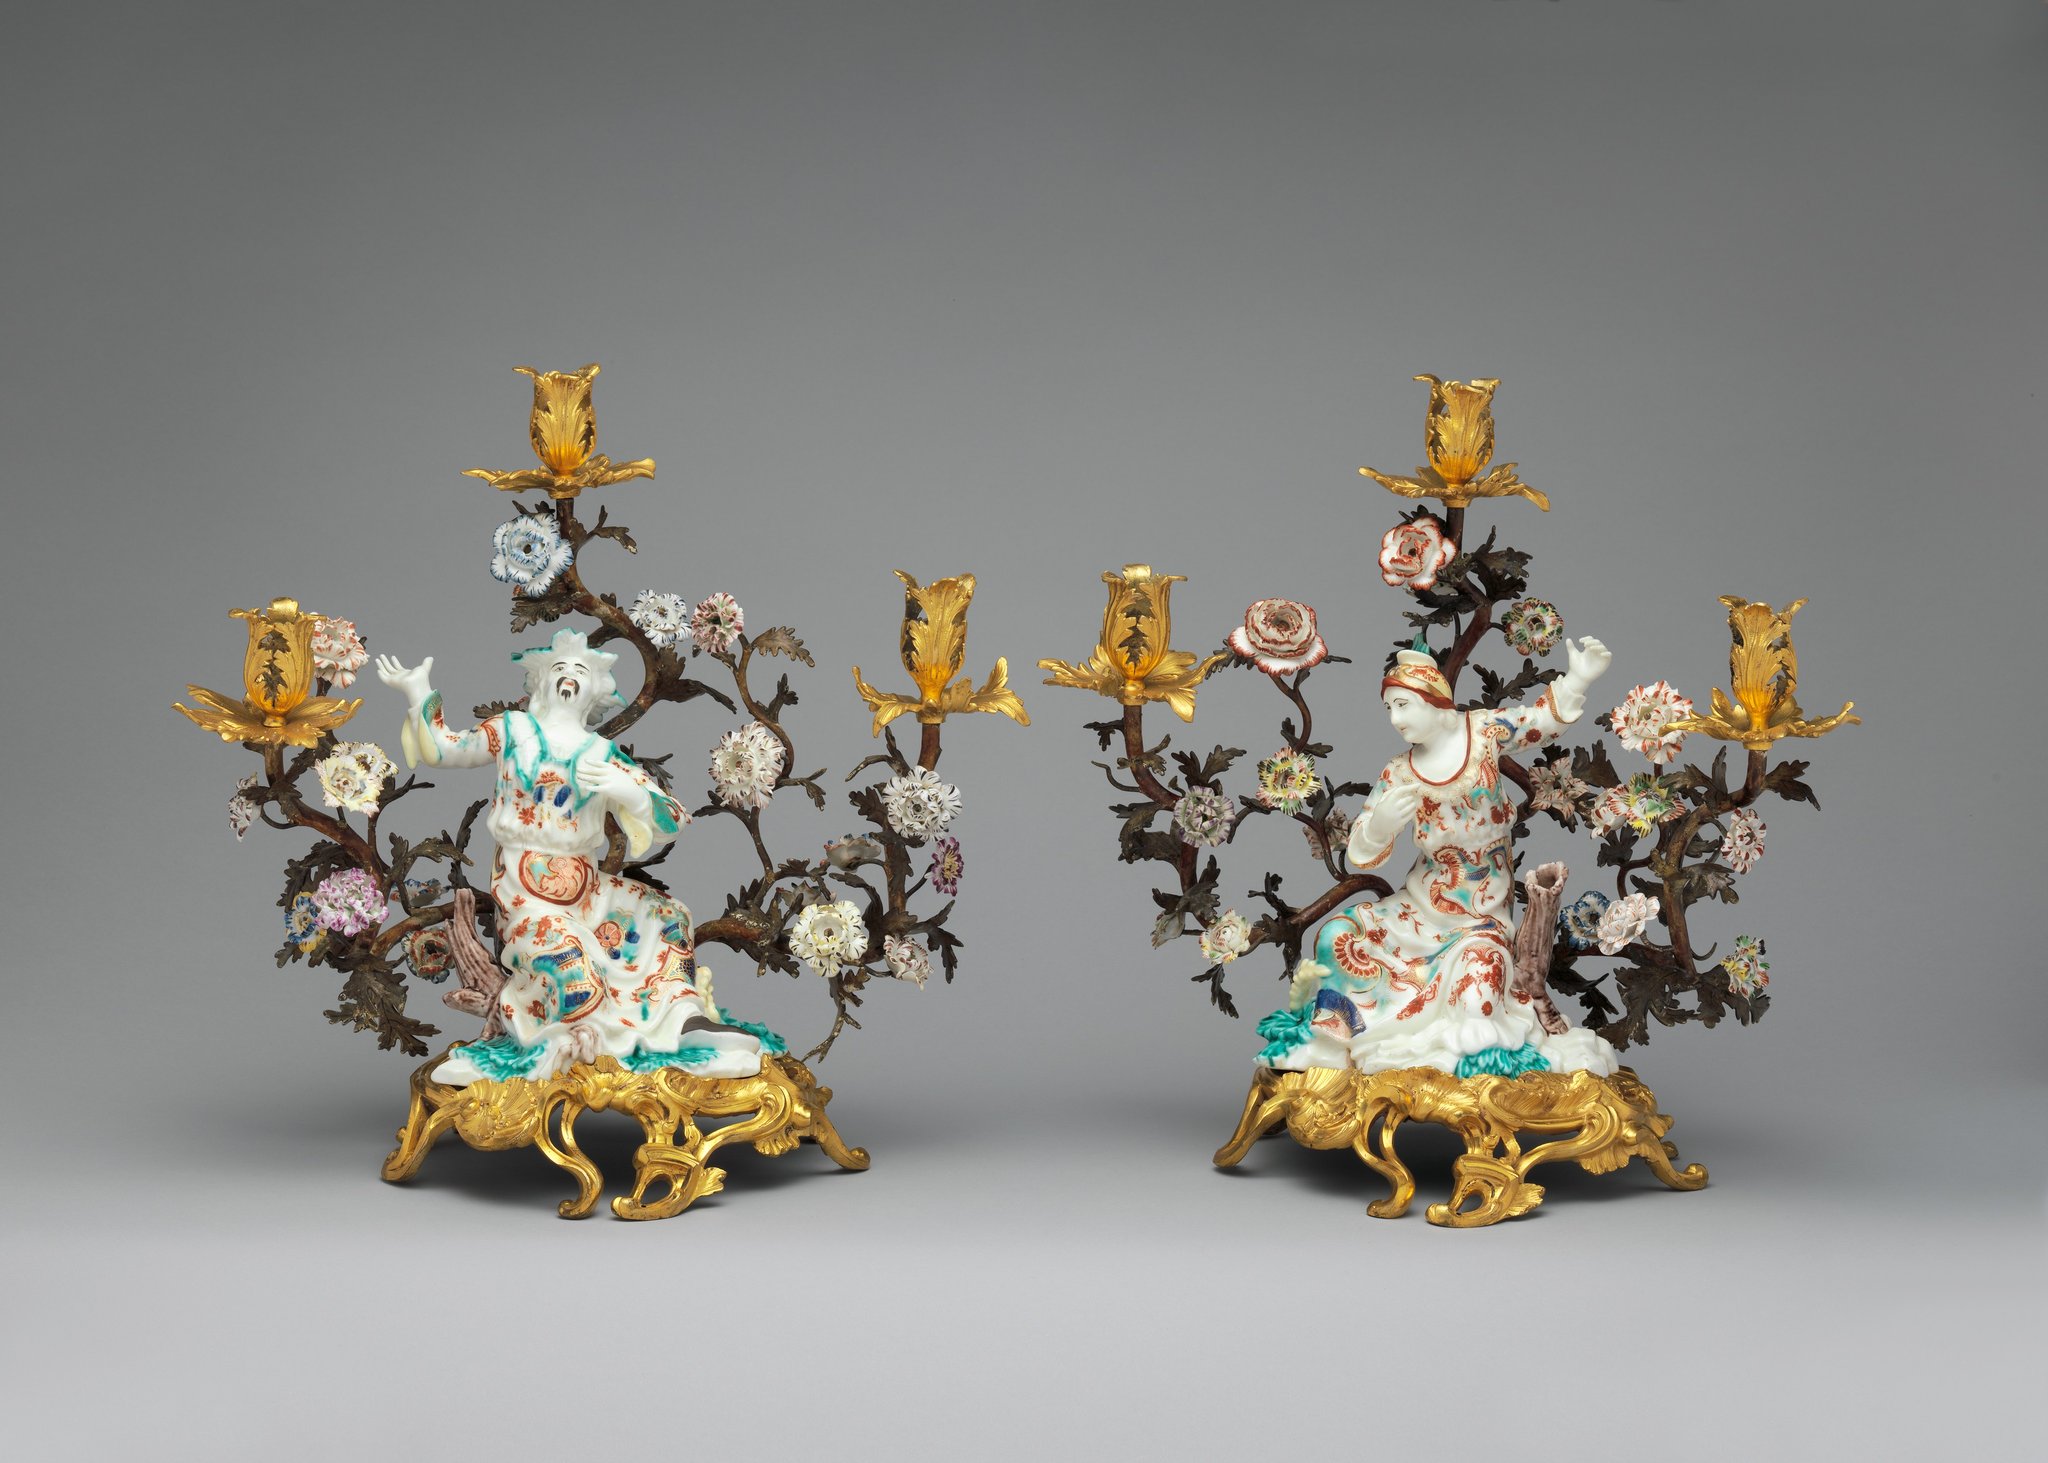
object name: candelabrum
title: Figure mounted as a candelabrum (one of a pair)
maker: saint-cloud factory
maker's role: factory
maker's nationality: french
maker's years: 1693-1766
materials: enamel, gilt bronze, gold, soft paste porcelain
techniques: polychrome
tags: men,women,flowers